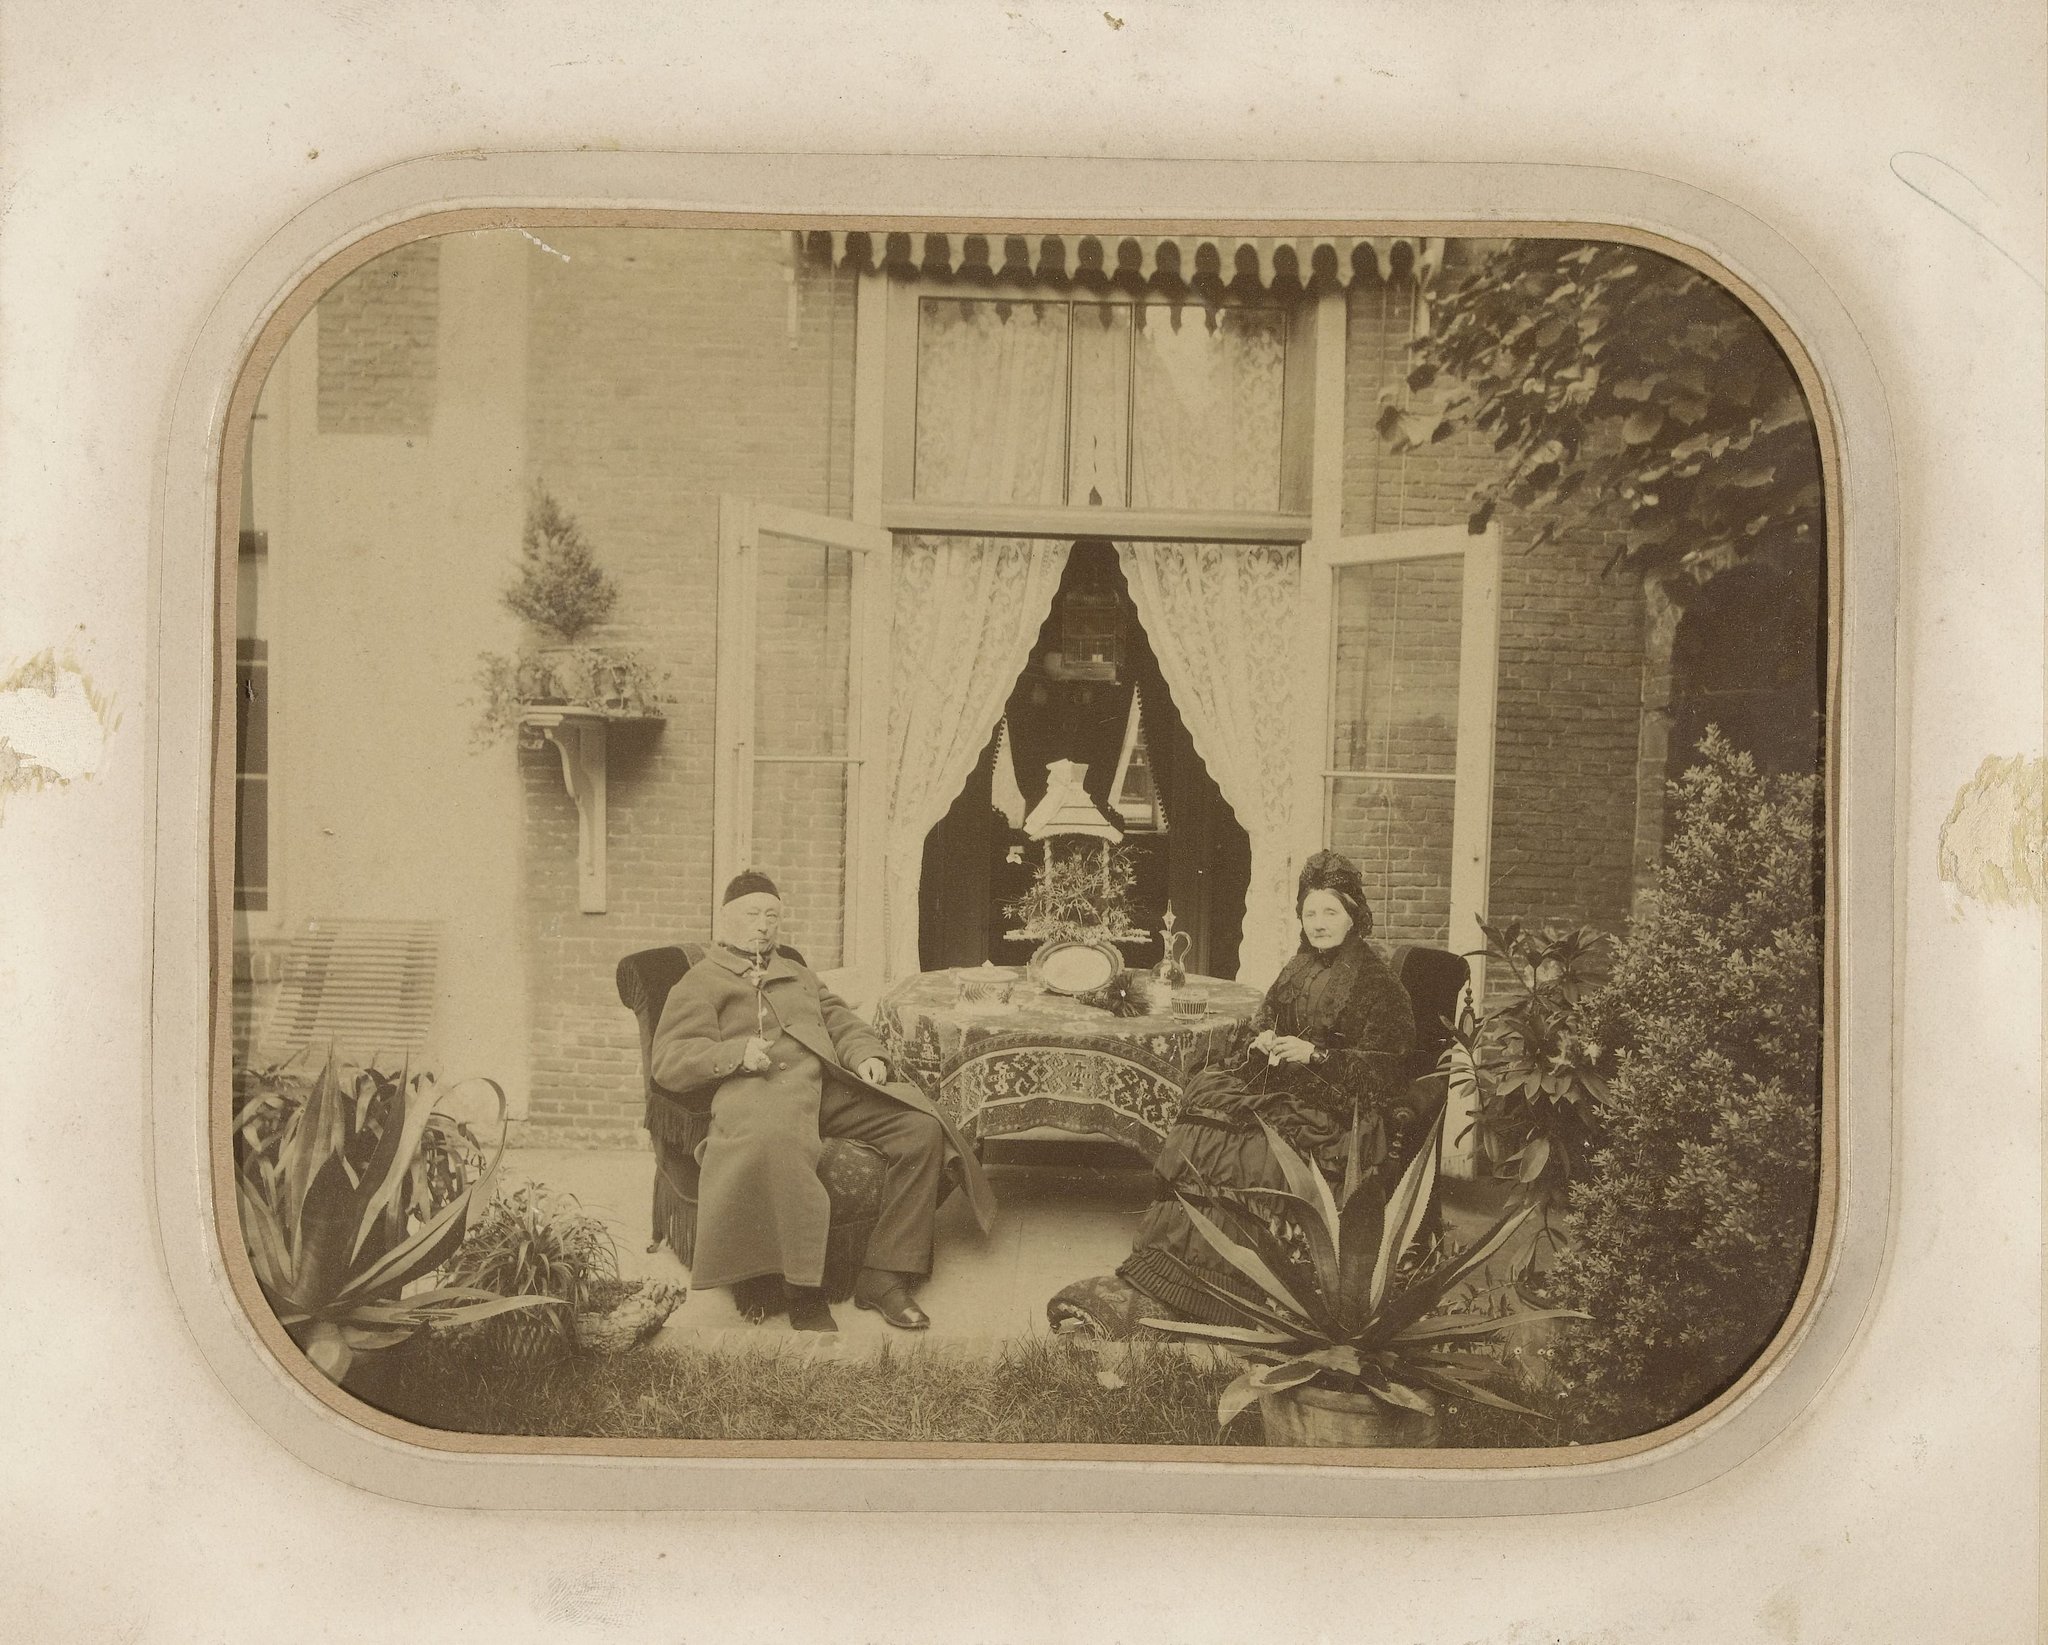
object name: photograph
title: Portret van een bejaard echtpaaraan tafel op een veranda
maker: Anonymous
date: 1880-1900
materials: photographic support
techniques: albumen print, gelatin silver print